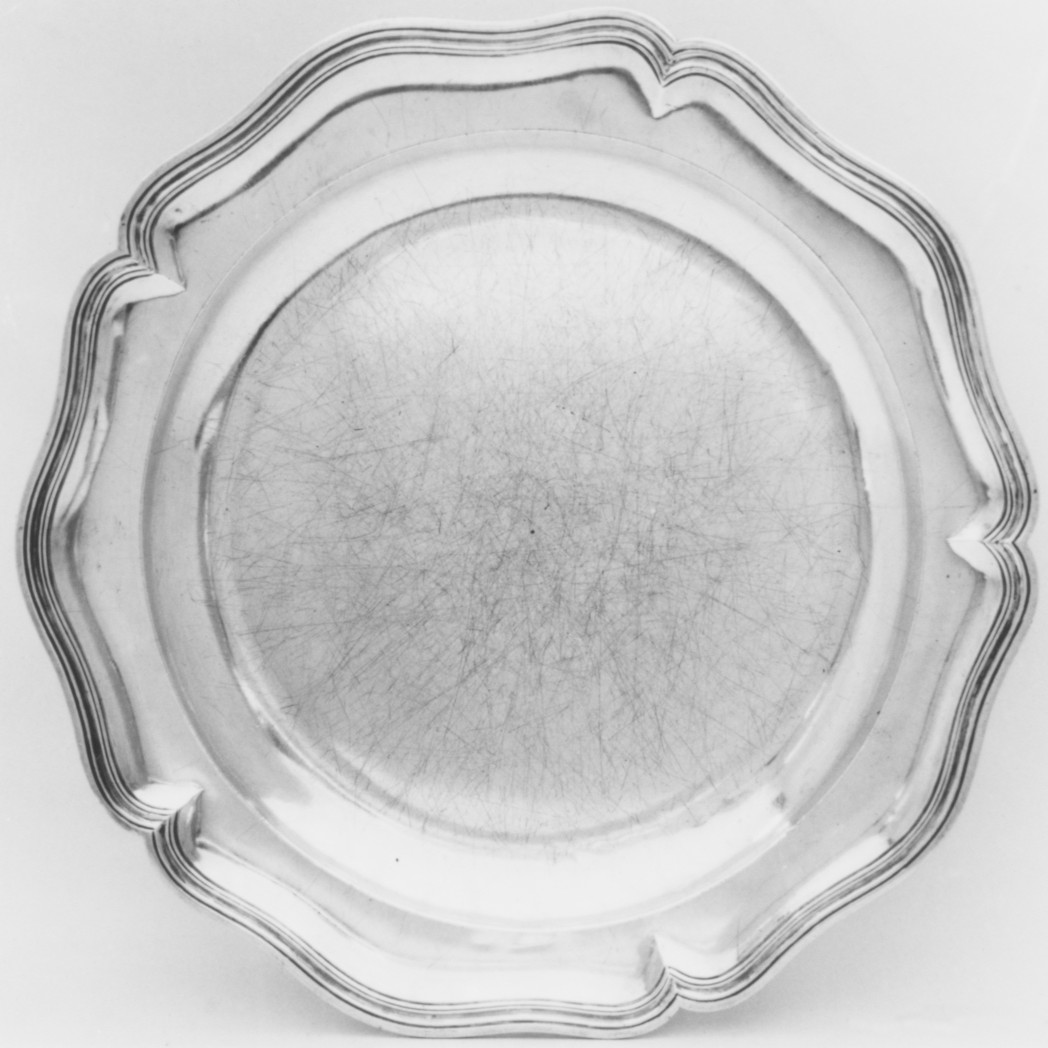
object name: plate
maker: i.b.c.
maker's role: maker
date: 1701-1800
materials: silver